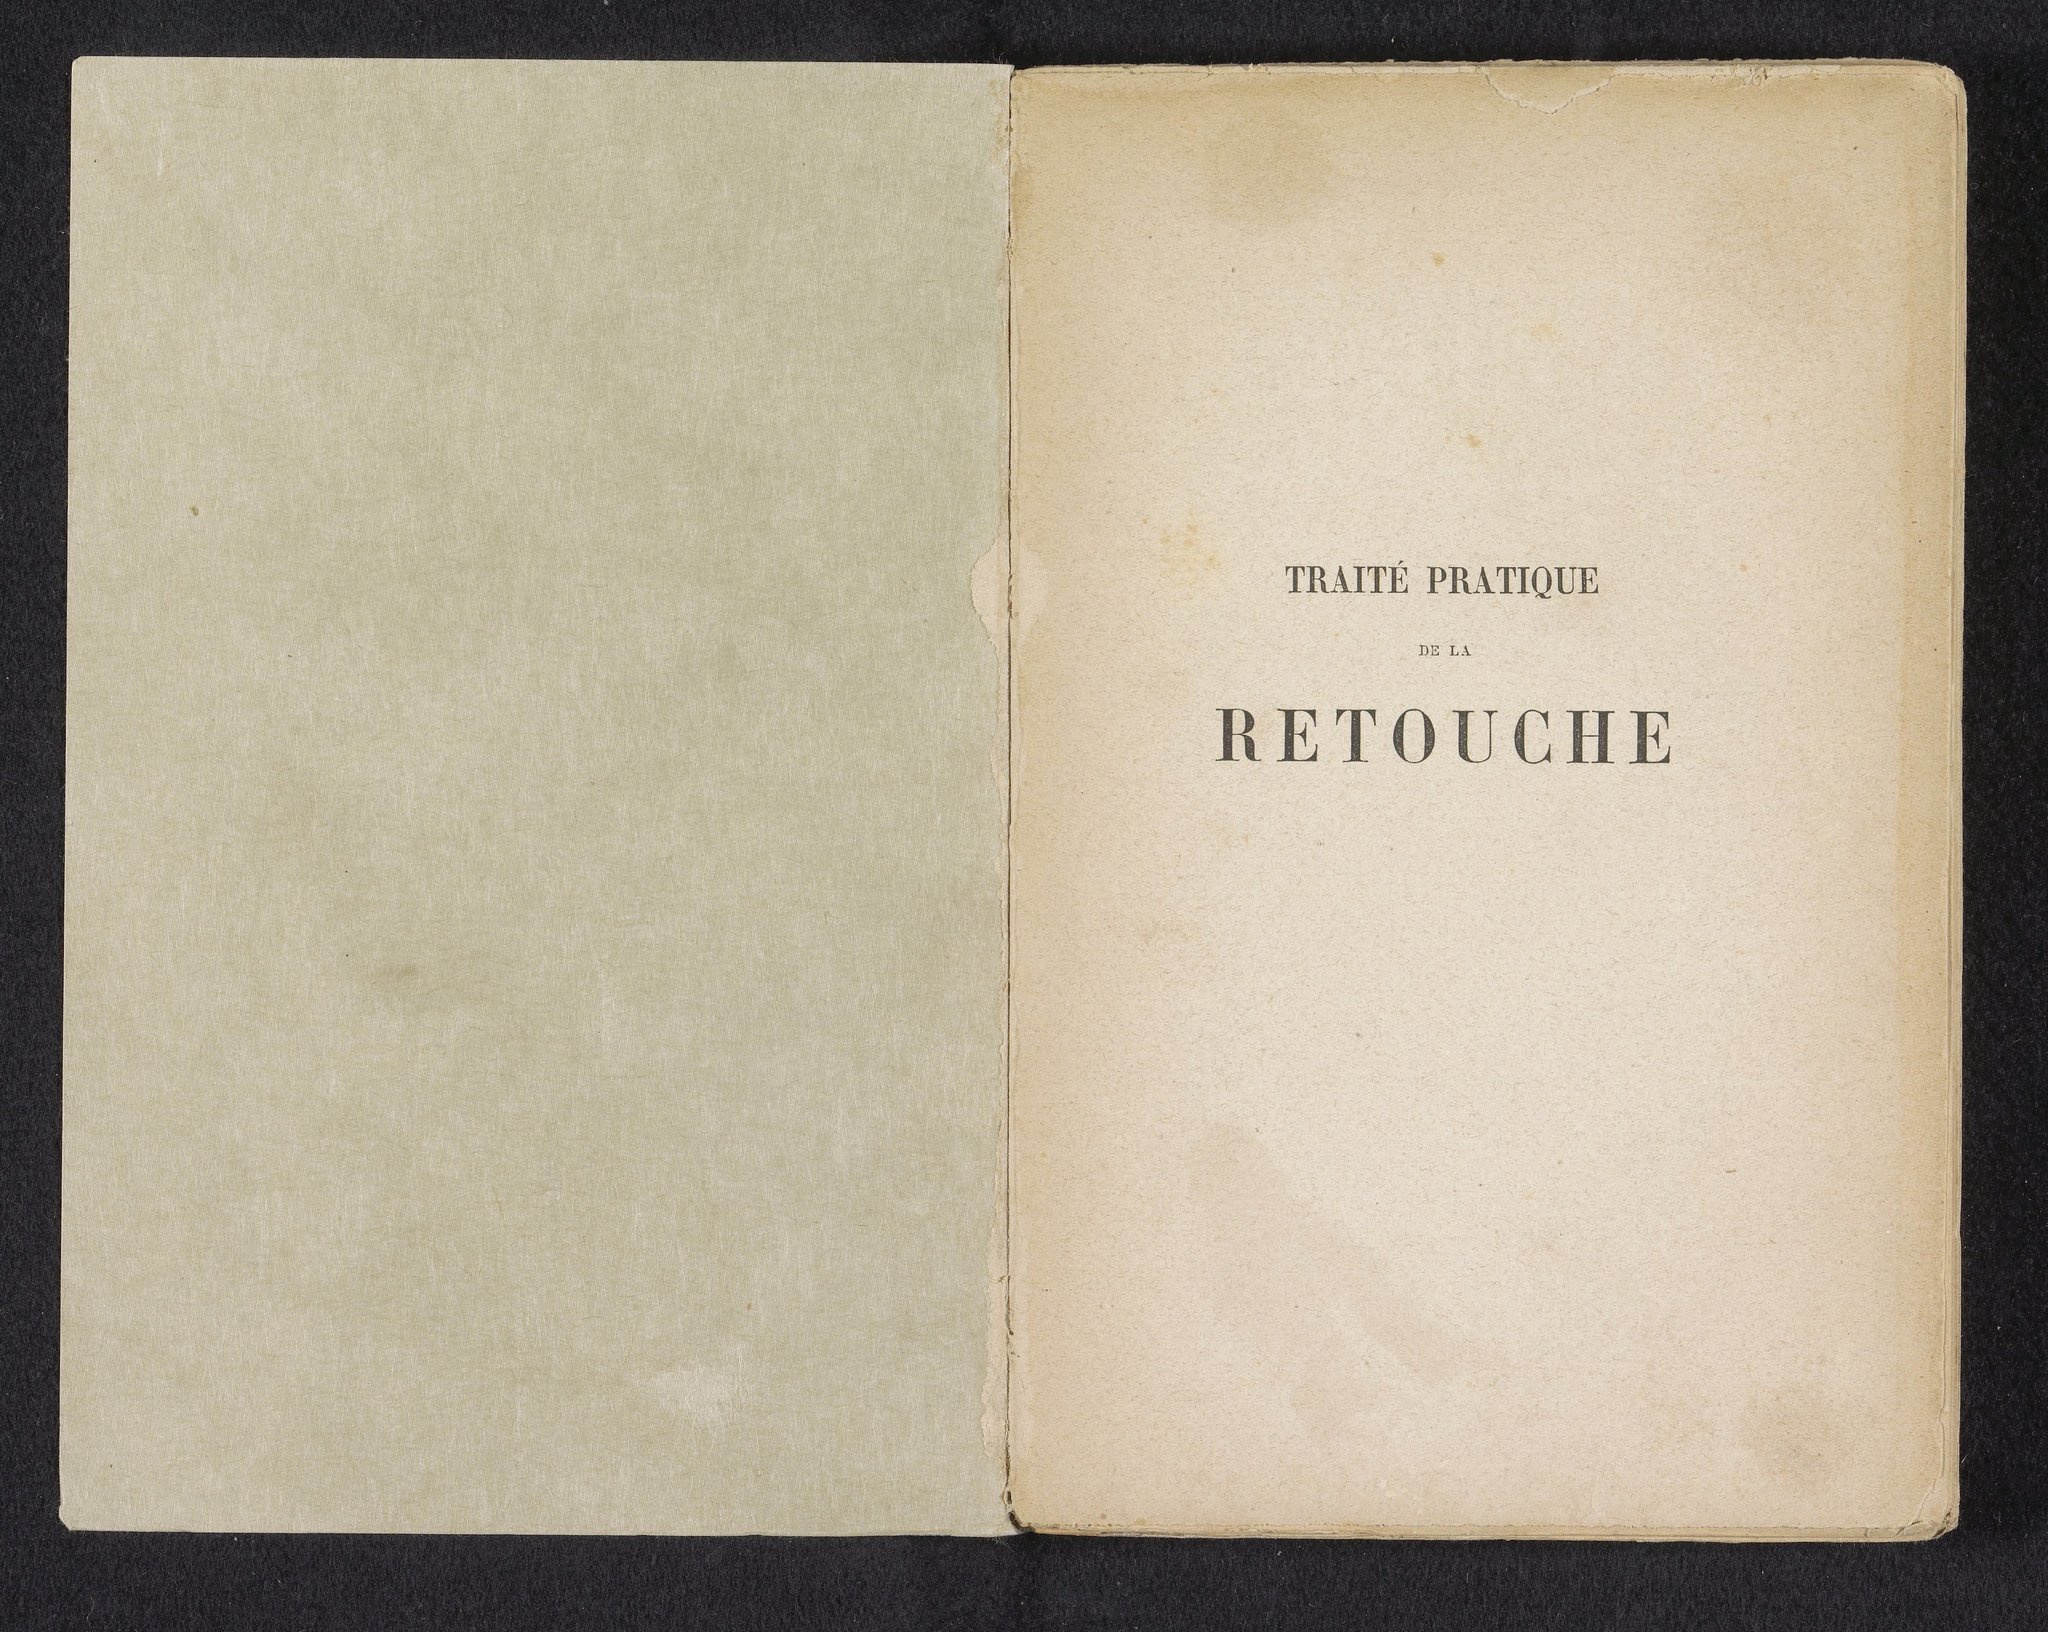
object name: book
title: Traité pratique de la retouche des clichés photographiques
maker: p. piquepé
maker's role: fotograaf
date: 1881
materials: paper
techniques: printing, woodburytype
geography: paris